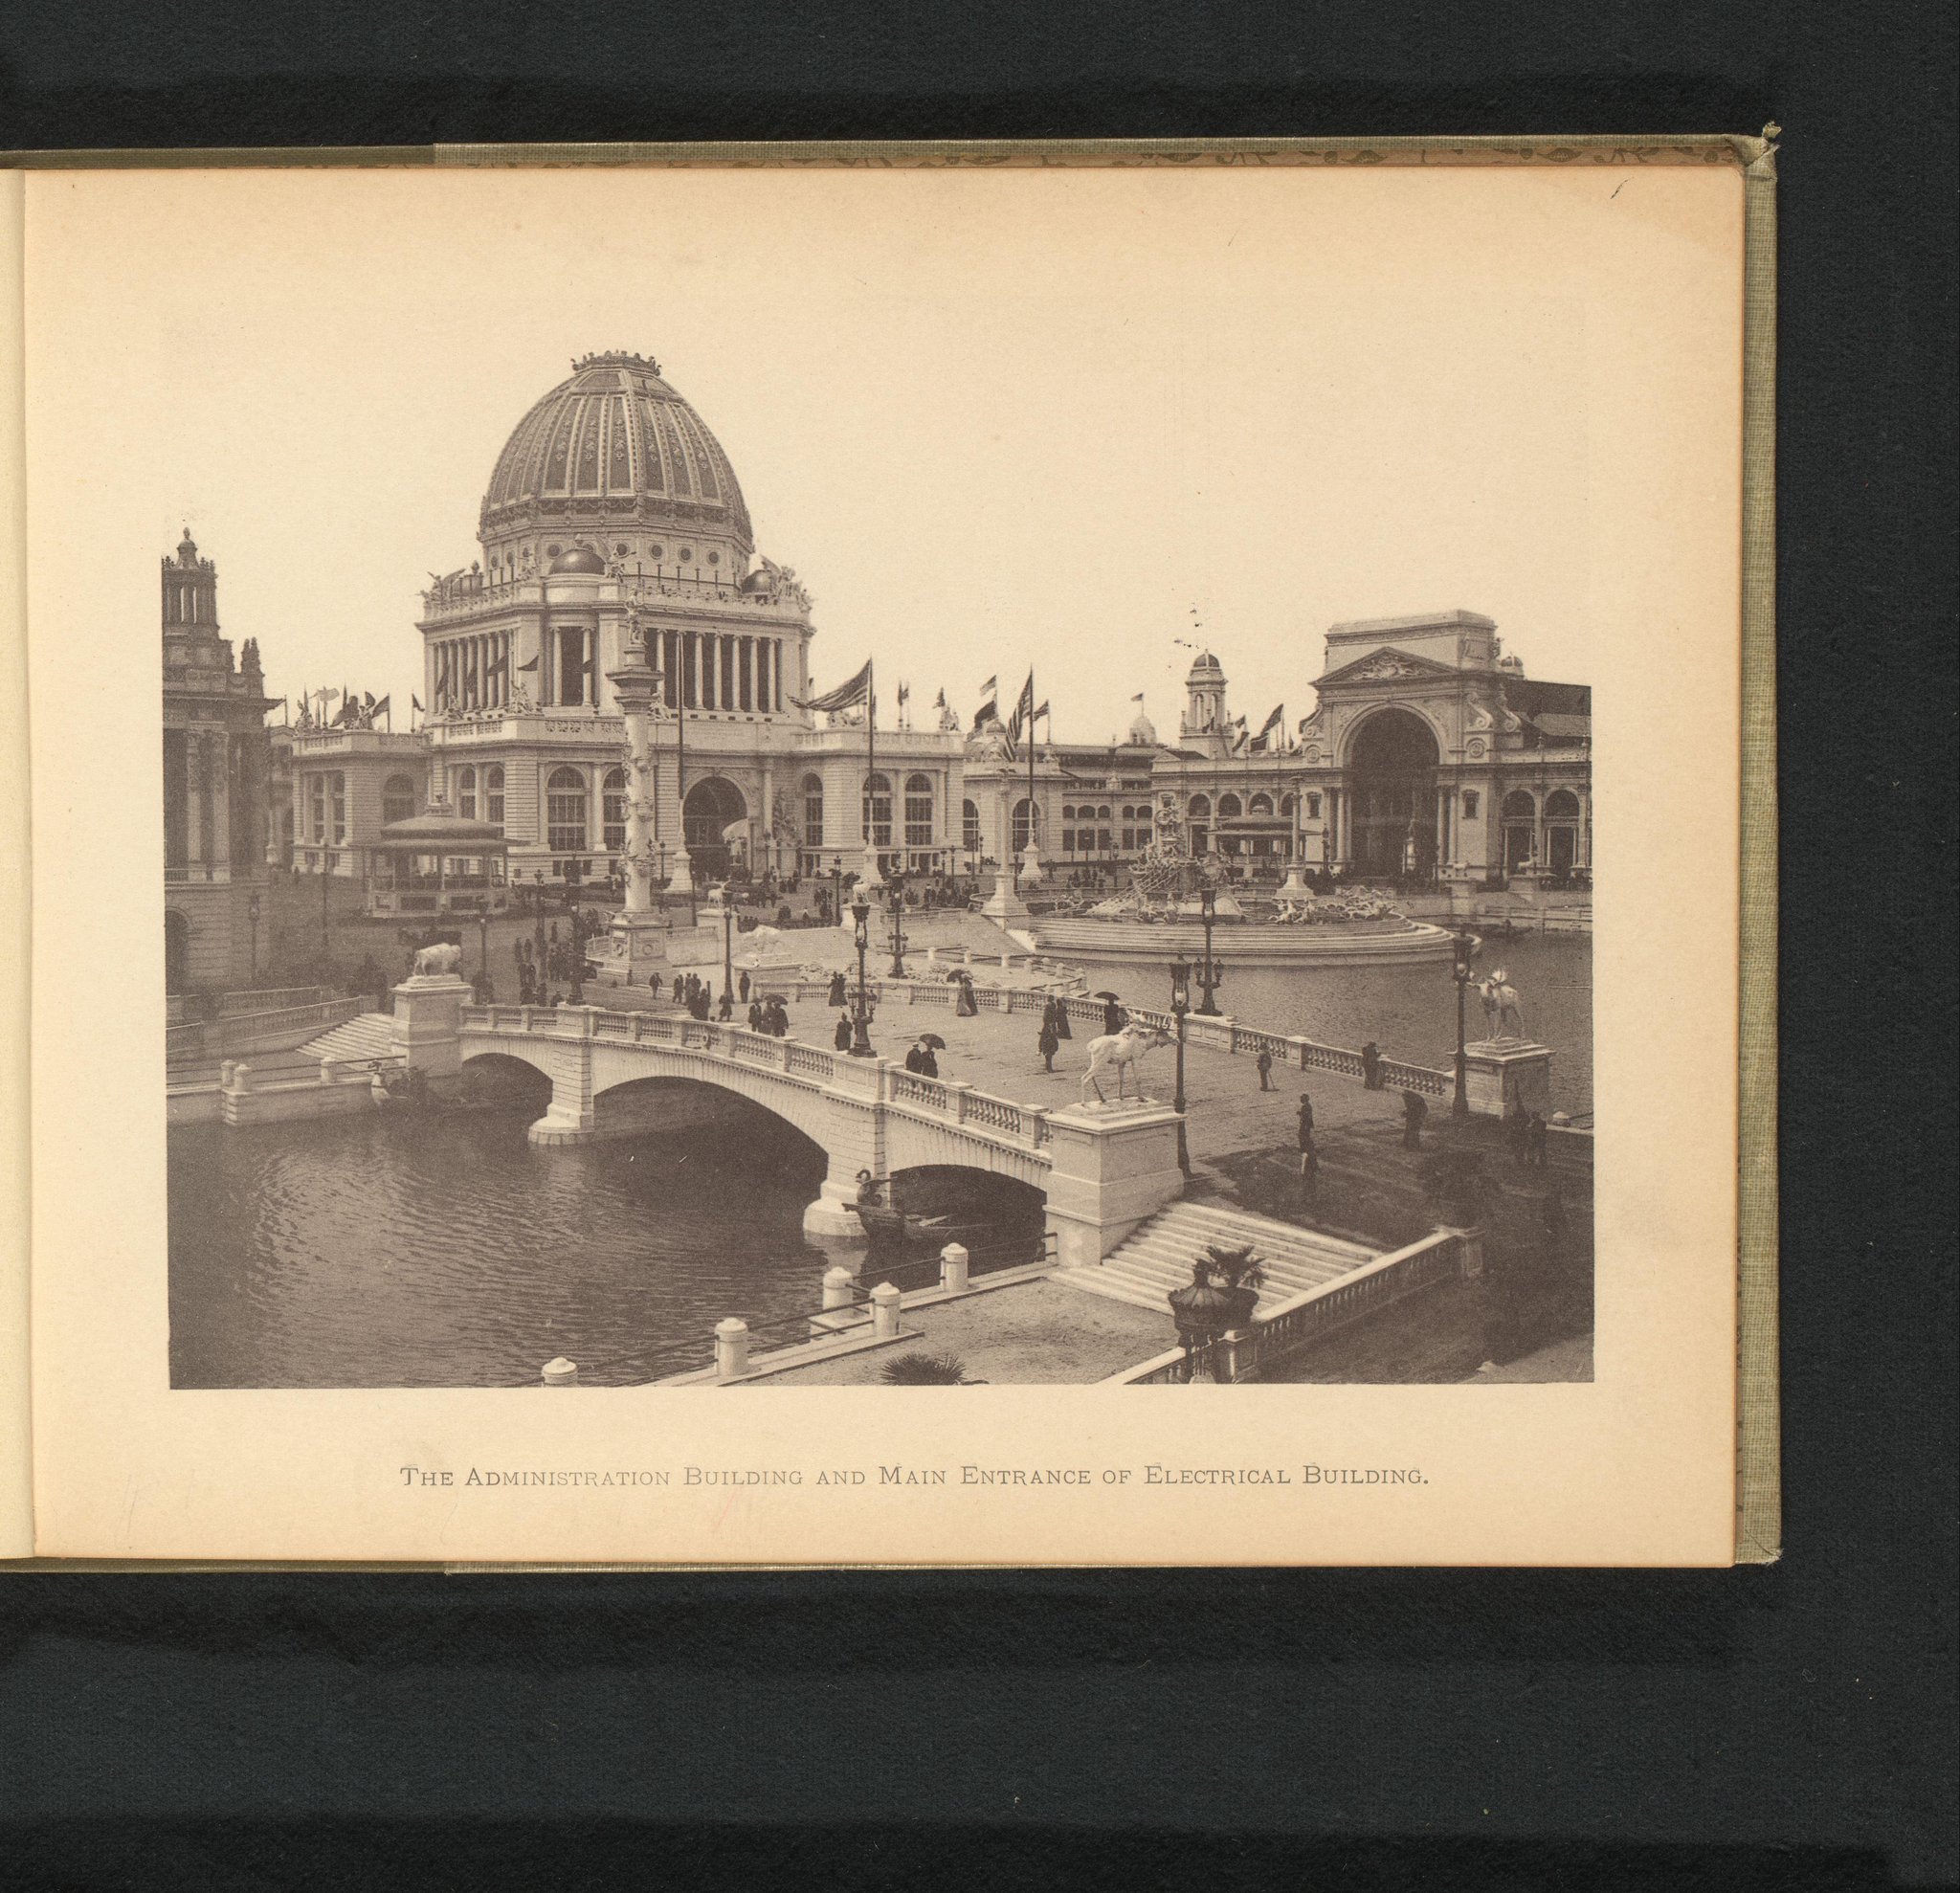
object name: page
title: The Administration Building and Main Entrance of Electrical Building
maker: Anonymous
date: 1893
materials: paper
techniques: photograph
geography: chicago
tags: world fair, world exhibition